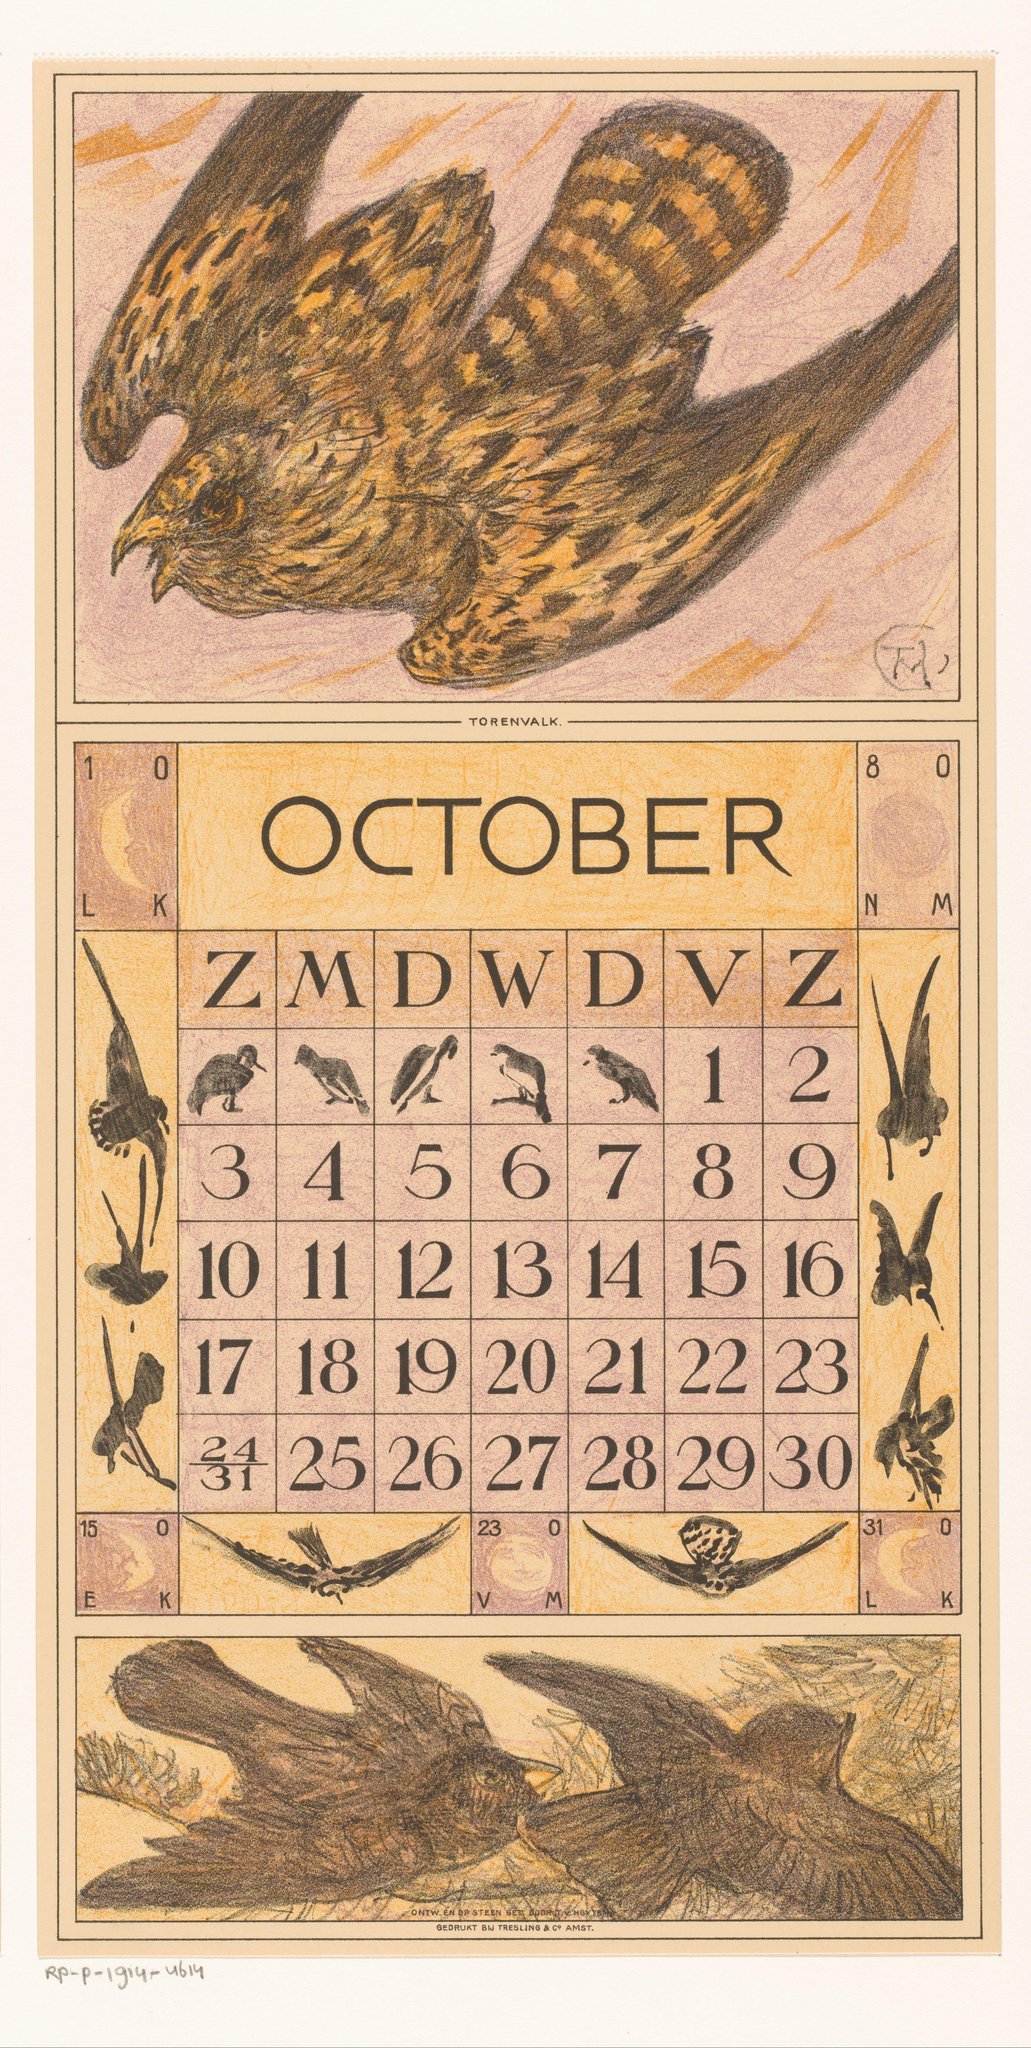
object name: print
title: Kalender 1915 12 lithografien door Th. v. Hoytema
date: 1914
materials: paper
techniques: lithograph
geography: the hague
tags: predatory birds: falcon, lunar year, october ~ other concepts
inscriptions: collector's mark: Lugt 2233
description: De kalender wordt genoemd in een advertentie van Allert de Lange in het Algemeen Handelsblad op 23-11-194, pagina 4.